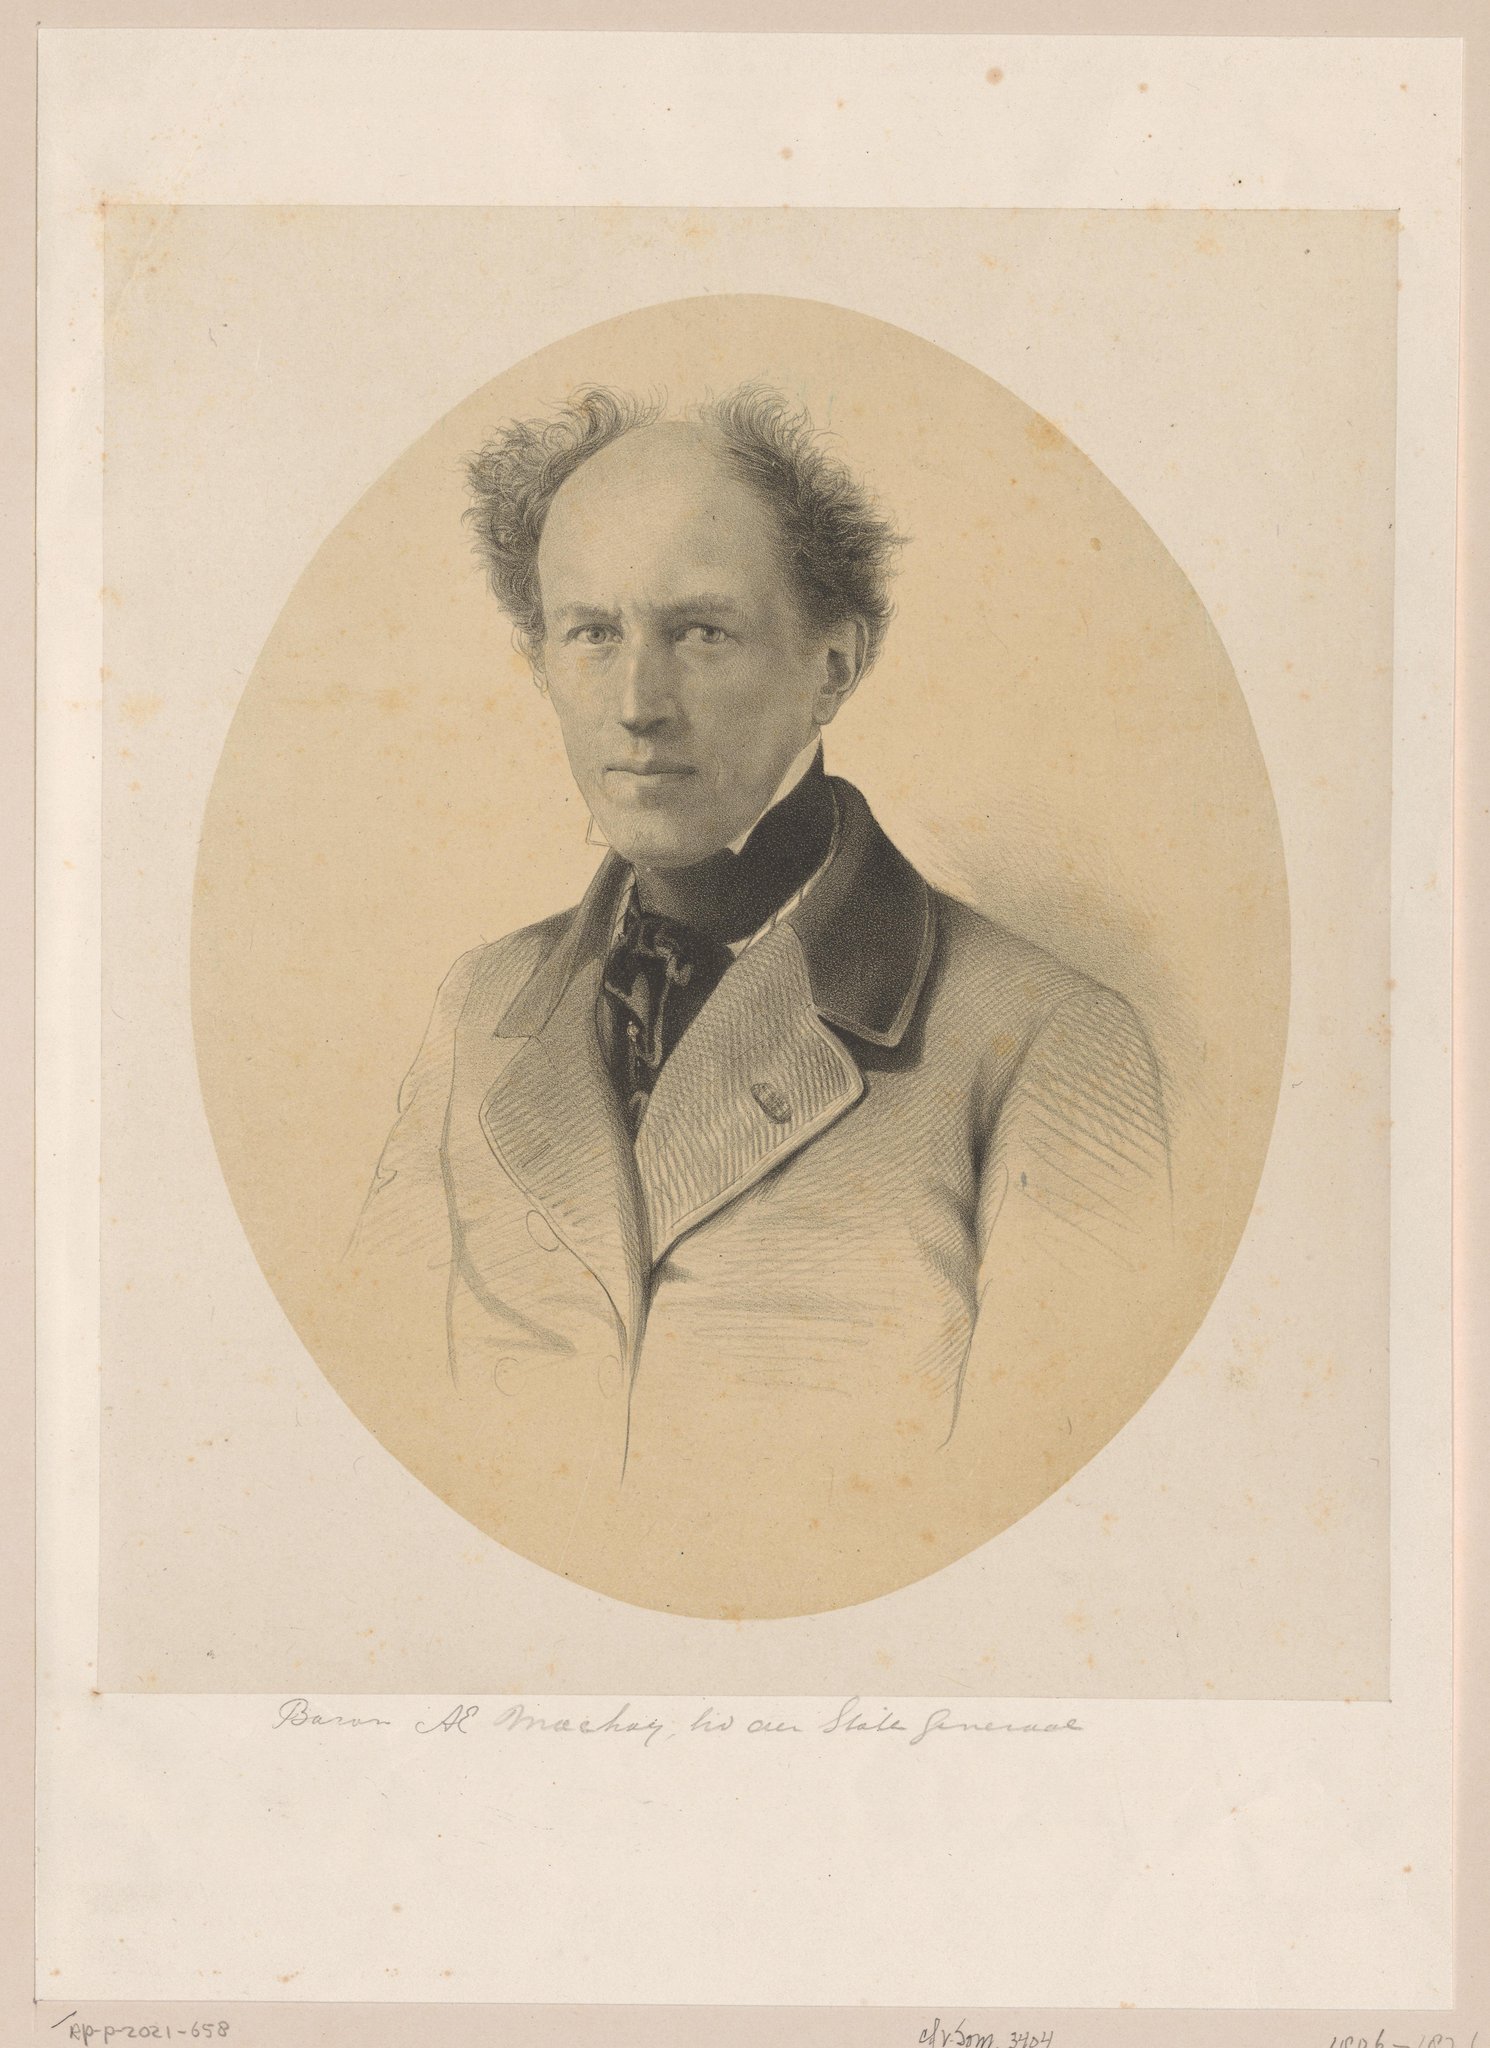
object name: print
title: Portret van Aeneas Mackay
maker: Anonymous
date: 1816-1876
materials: paper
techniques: tone lithography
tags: nijmegen, the hague, historical persons, physician, doctor (+ portrait of scholar, scientist), professor